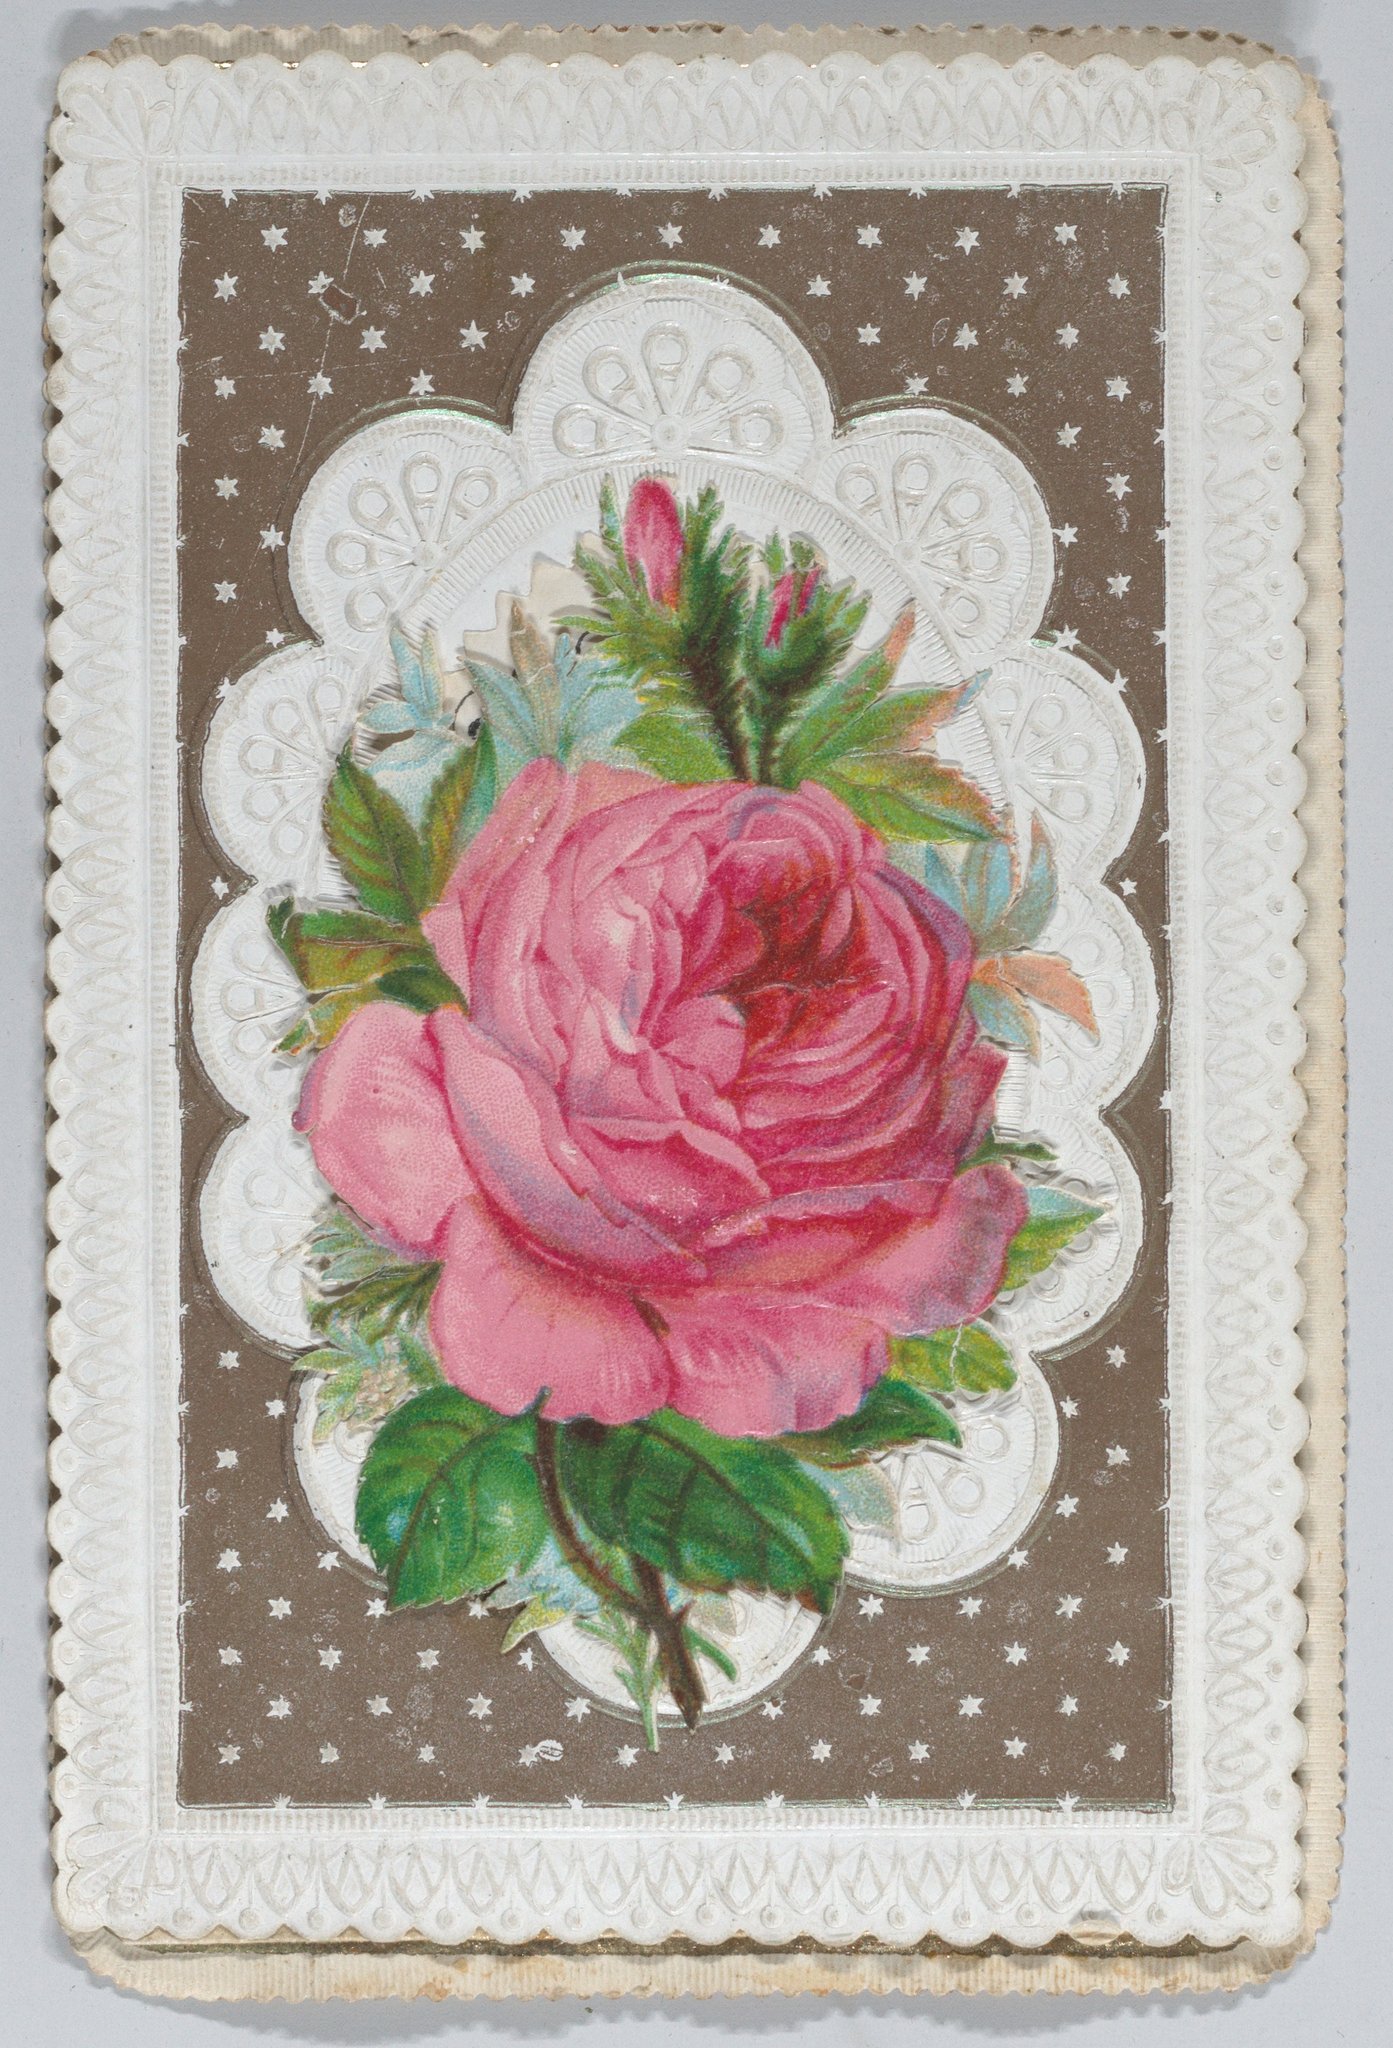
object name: valentine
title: Valentine - Mechanical Layered Birthday - die cut roses and woman.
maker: Anonymous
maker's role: artist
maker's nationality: british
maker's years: 1800-1899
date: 1875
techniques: chromolithography, cutting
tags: flowers